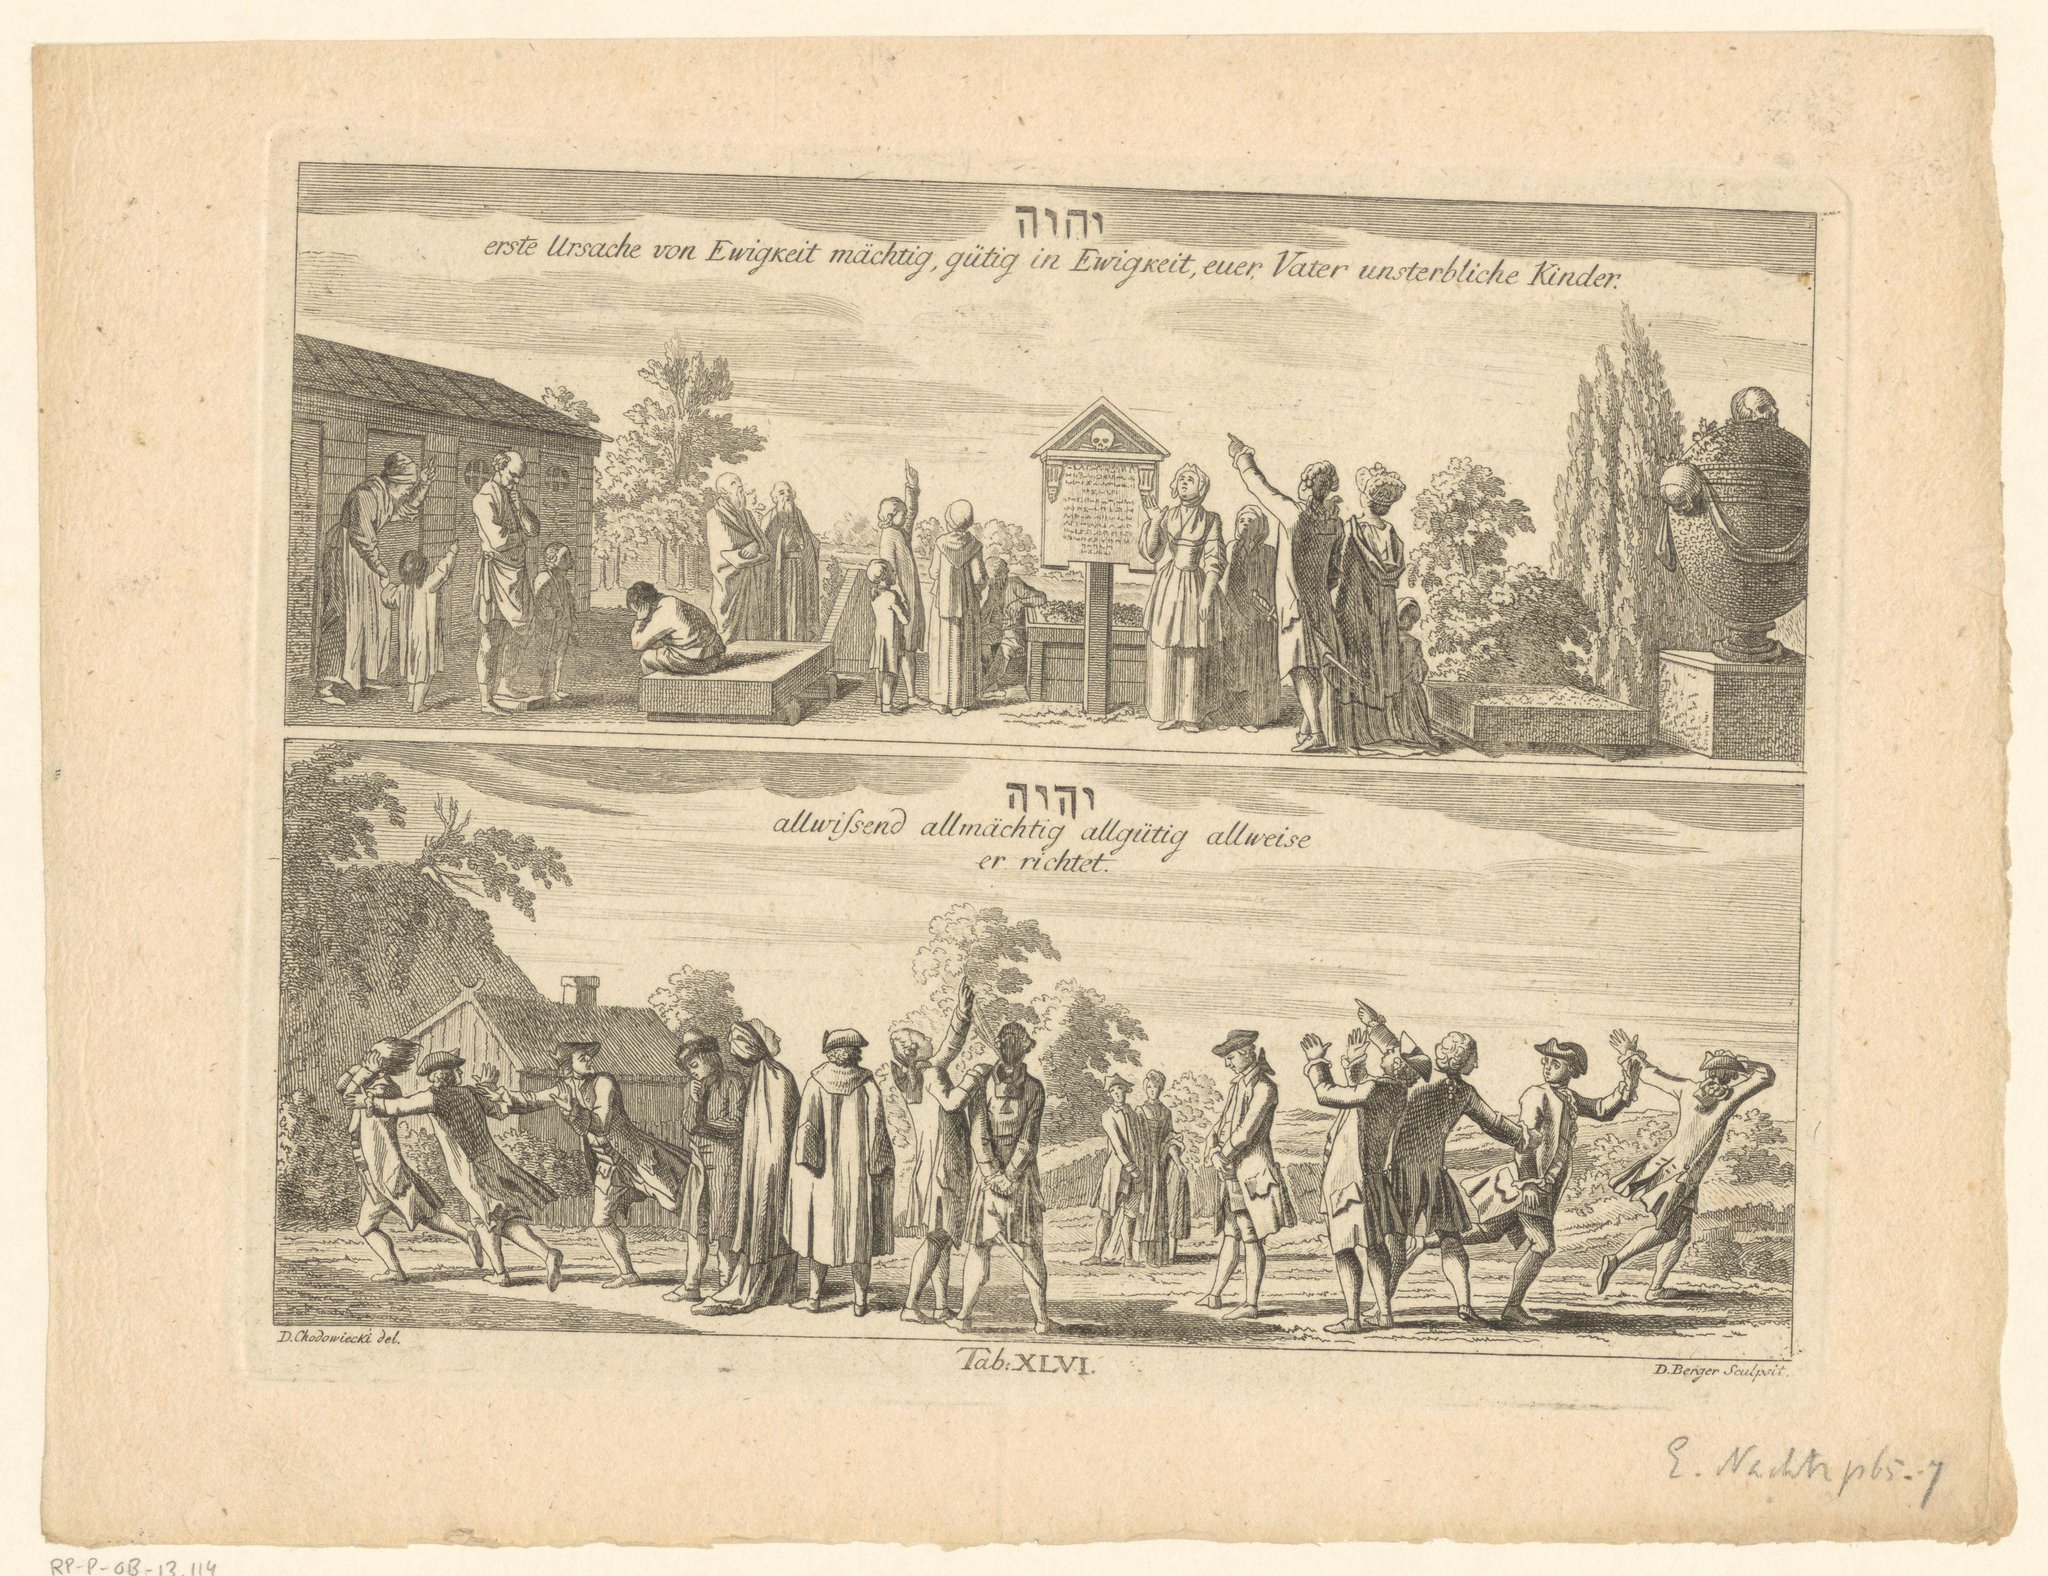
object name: print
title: Mensen zien een tetragram in de lucht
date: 1774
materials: paper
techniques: etching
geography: berlin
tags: johann bernhard basedow, tetragram (in roman or hebrew script) ~ symbol of god the father, churchyard, cemetery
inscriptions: collector's mark: Lugt 2228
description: De prent maakt onderdeel uit van een serie van 96 prenten die verschenen ter illustratie van het 'Elementarwerk' van de Duitse pedagoog Johann Bernhard Basedow. De prenten werden door verschillende kunstenaars vervaardigd naar tekeningen van Daniel Chodowiecki. In 1774 verscheen het verzamelde prentwerk bij Crusius in Leipzig onder de titel: Kupfersammlung zu J.B. Basedows Elementarwerk für die Jugend und ihre Freunde.